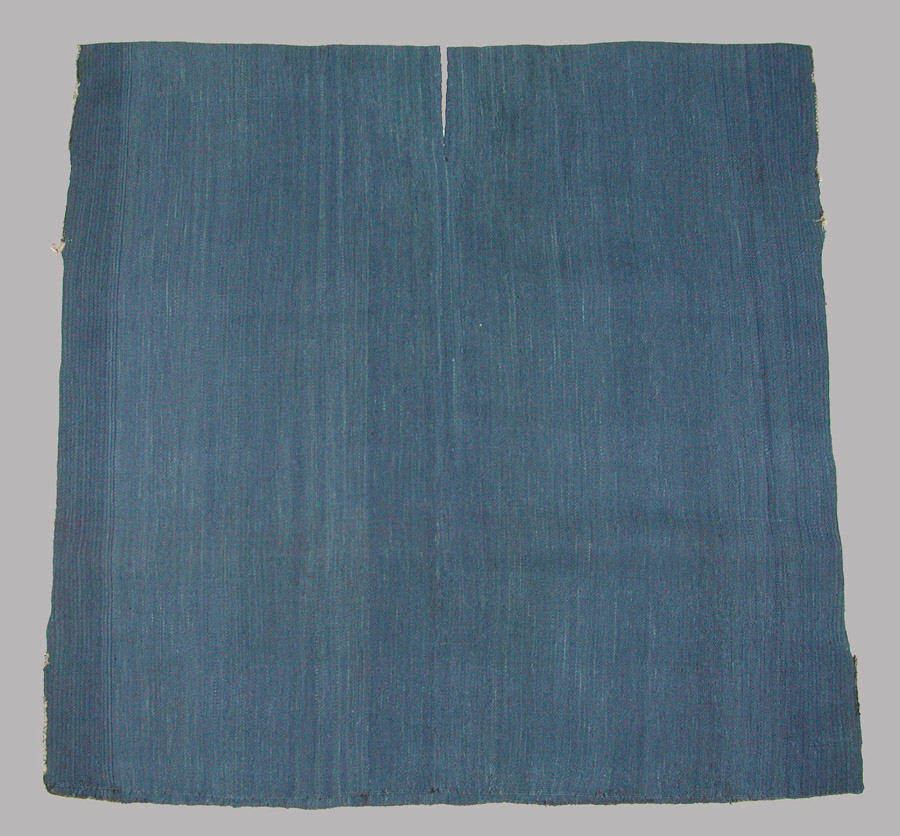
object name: tunic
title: Man's Tunic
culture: aymara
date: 1601-1800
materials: animal fiber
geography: bolivia